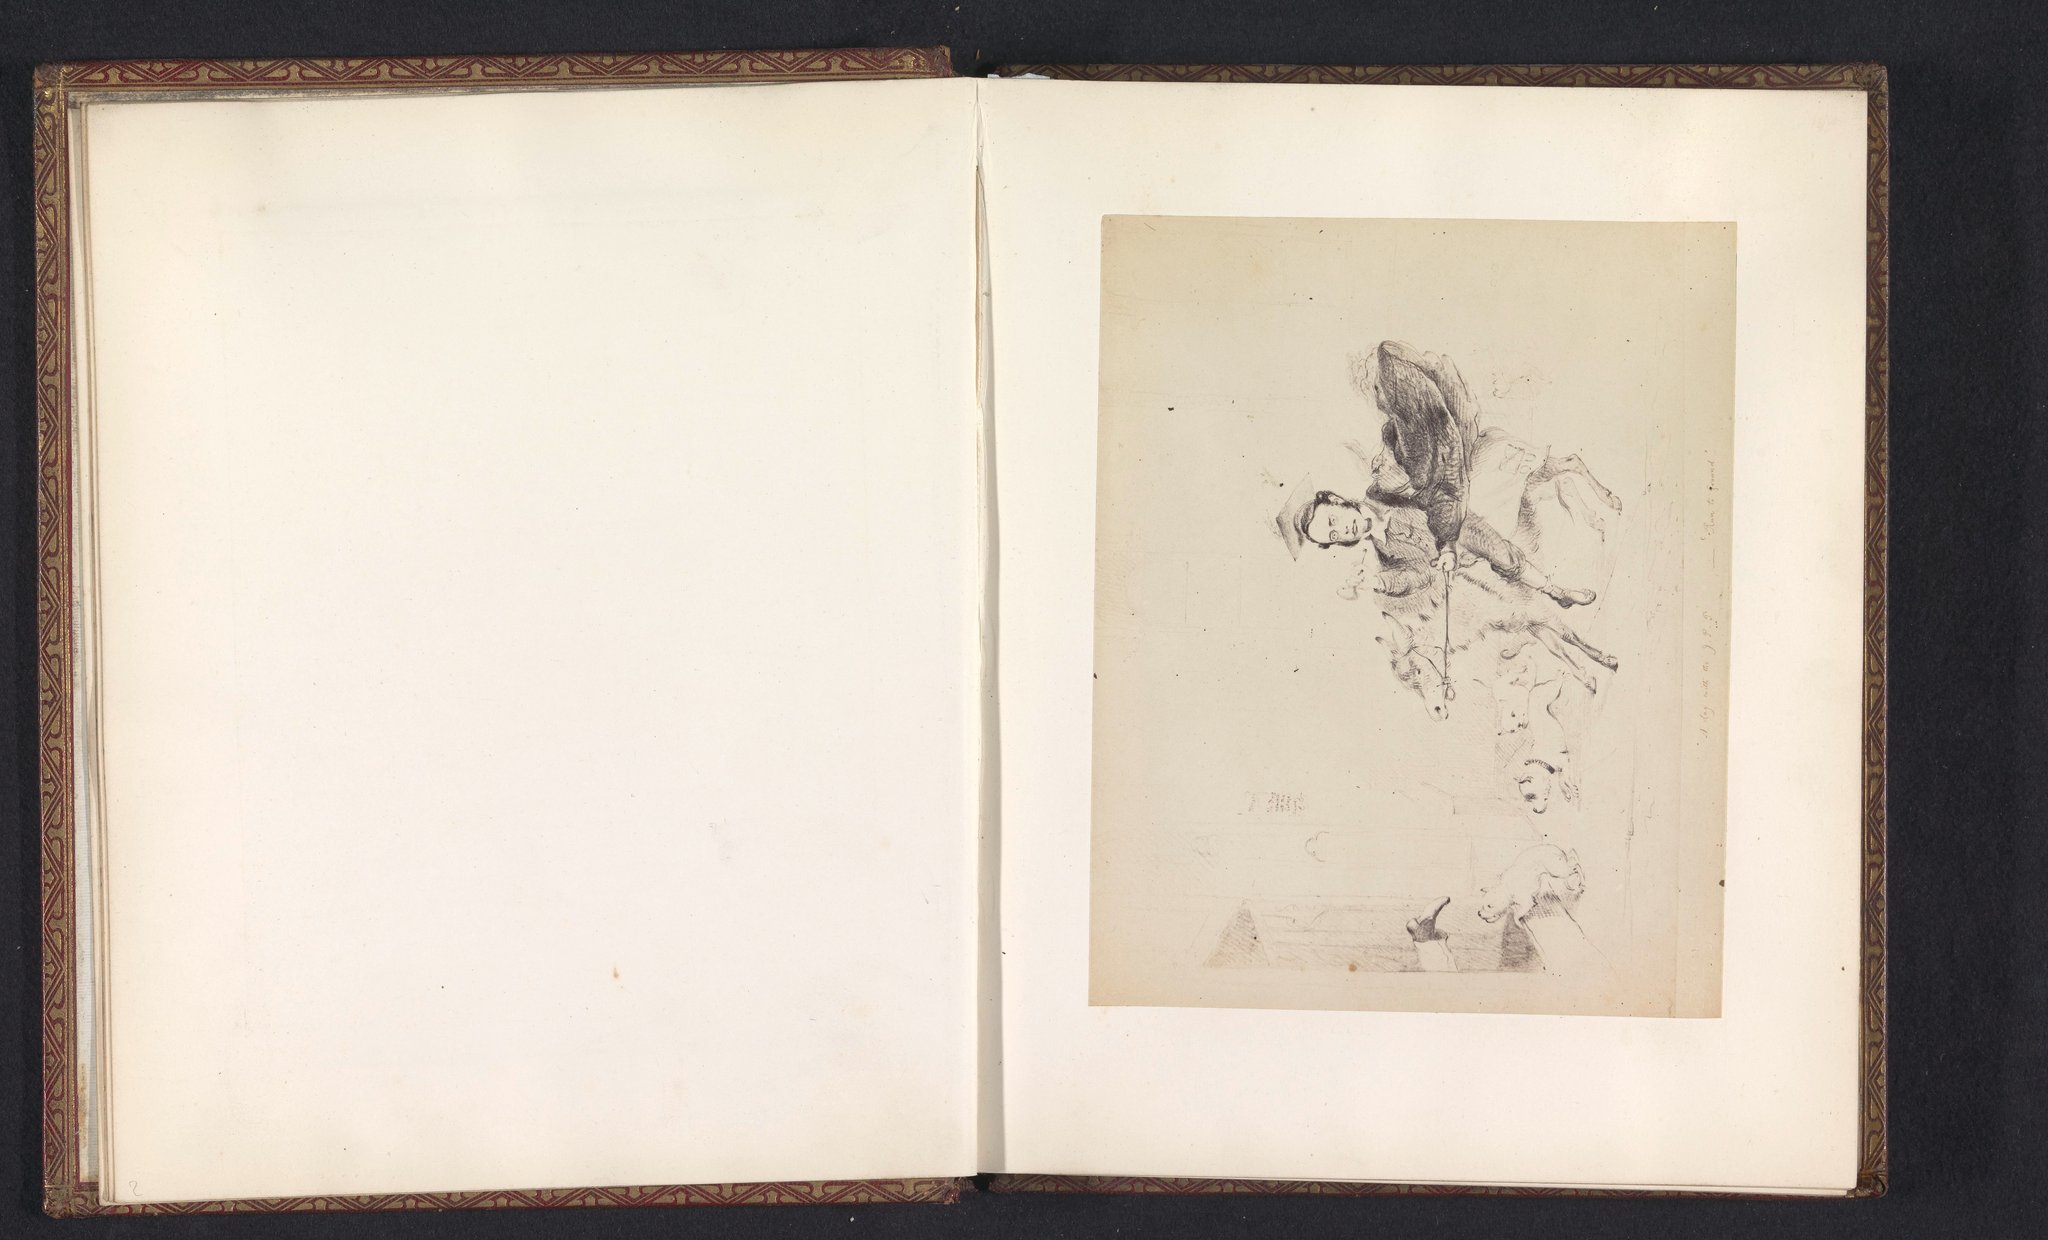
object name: photograph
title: Fotoreproductie van een tekening, voorstellende procurator F. Harrison op een ezel jaagt op een student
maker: Anonymous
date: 1855-1866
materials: photographic support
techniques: albumen print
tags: ass, donkey, caricatures (human types), student life, dog